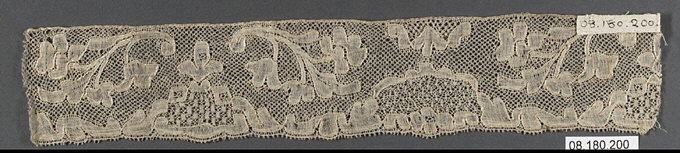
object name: fragment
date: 1801-1900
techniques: lace